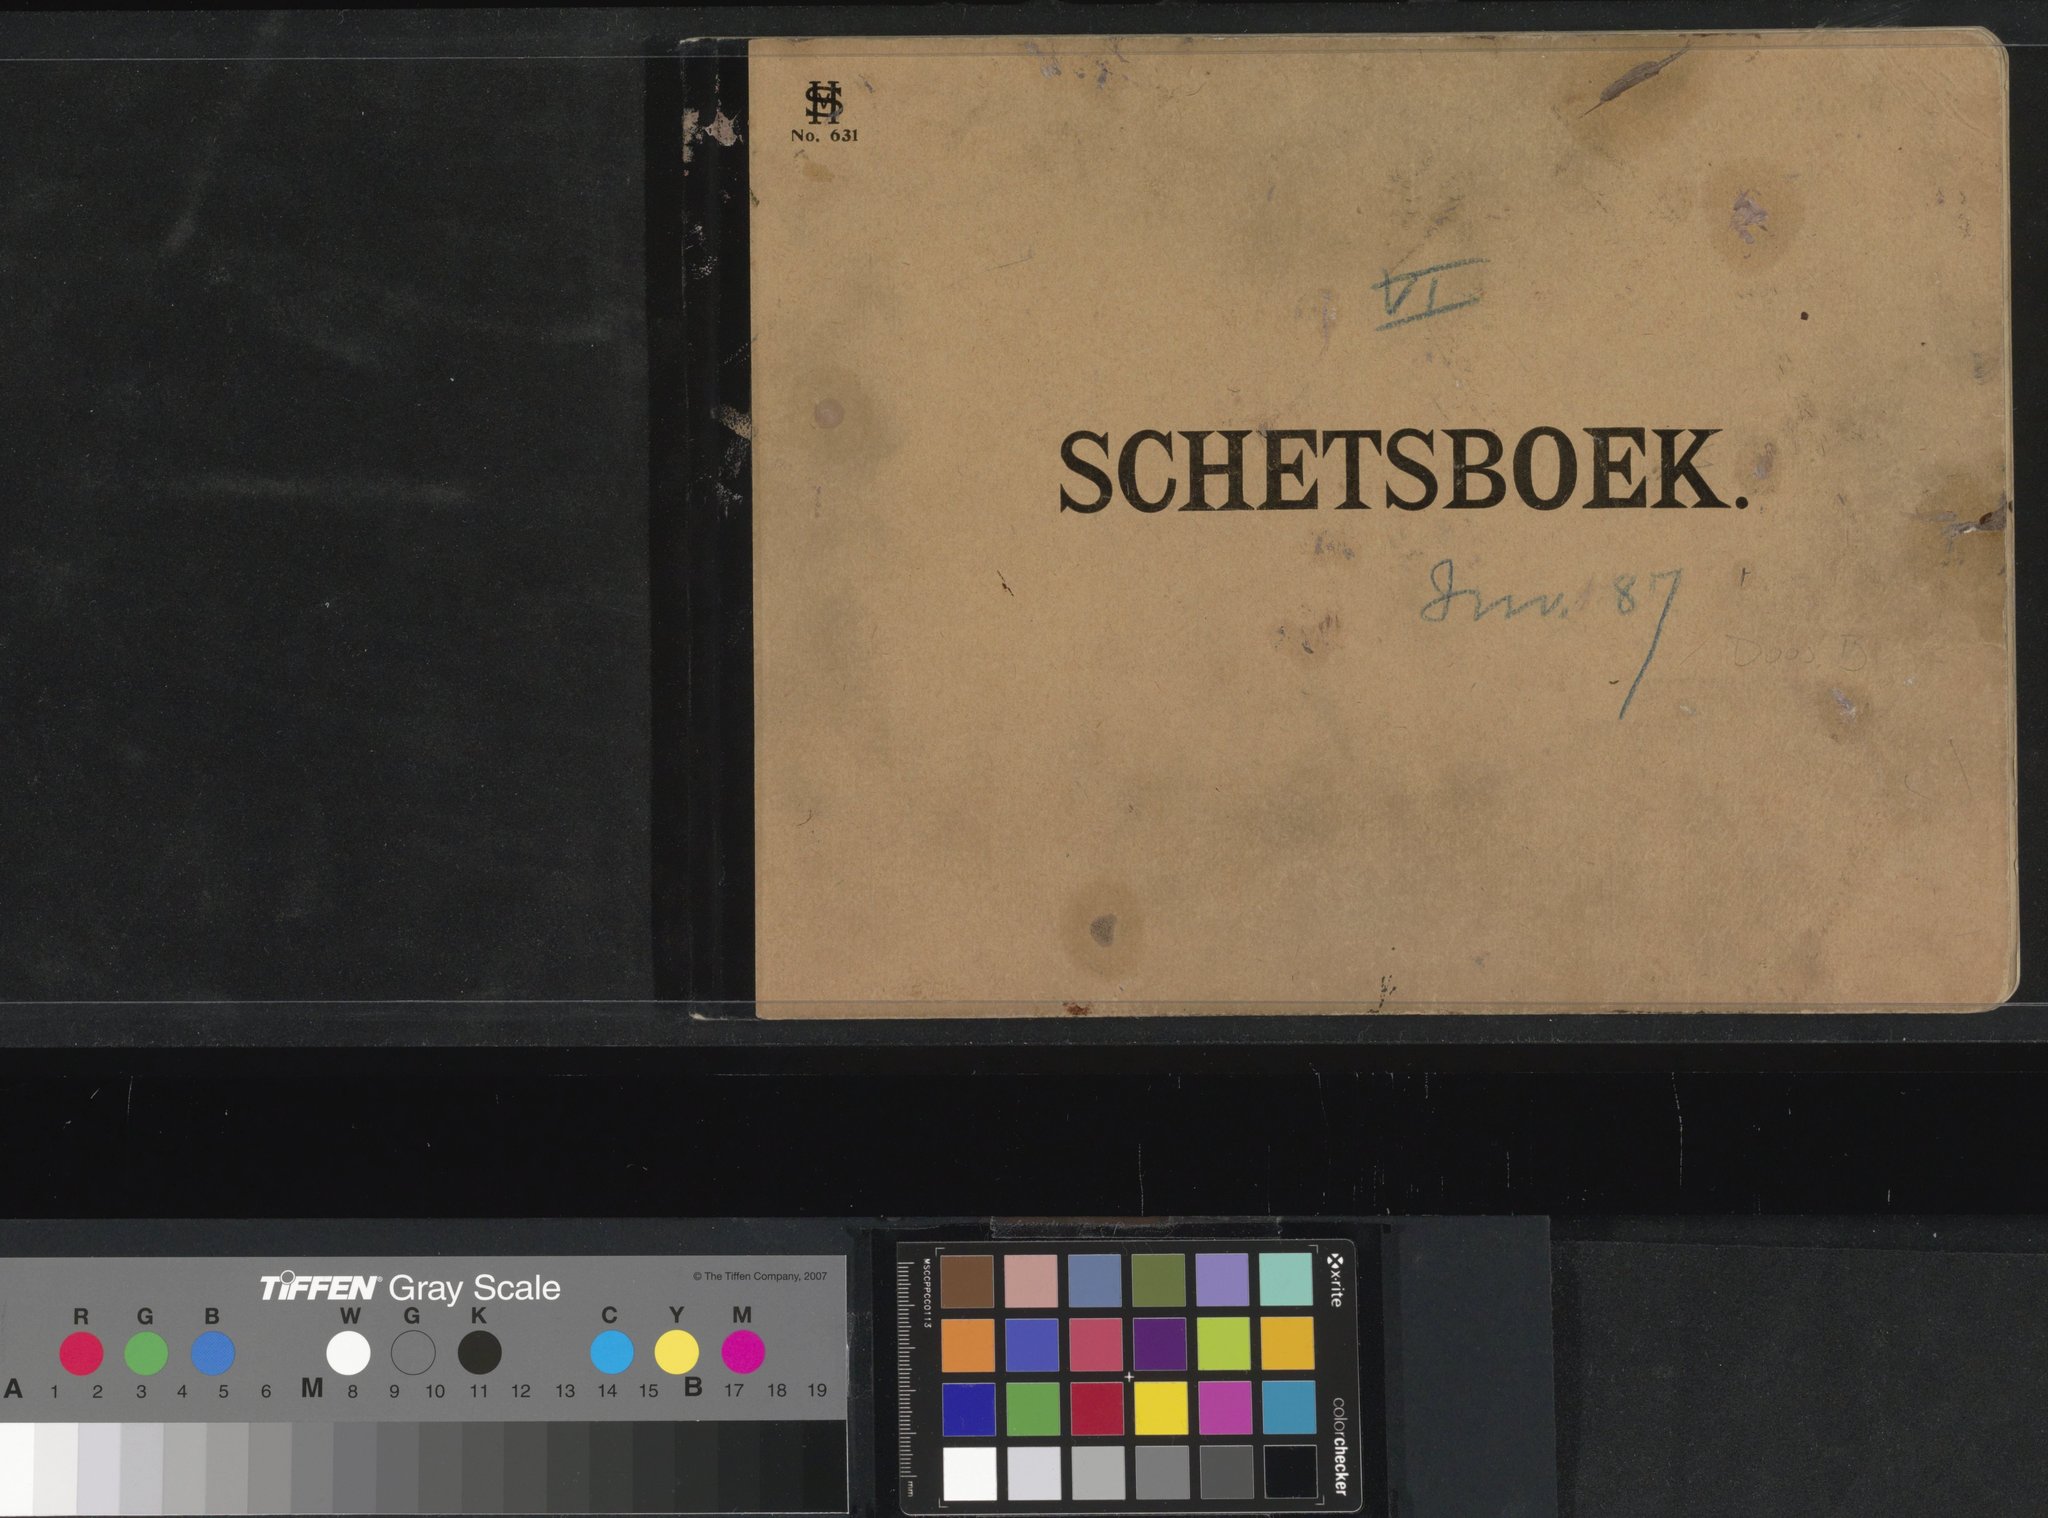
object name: sketchbook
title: Schetsboek VI met 33 bladen met variété en vrouwelijk naakt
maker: isaac israels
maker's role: draughtsman, painter, print maker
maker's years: 1865-1934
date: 1915-1934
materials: cardboard, chalk, ink, linen, paper, pencil, watercolor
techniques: brush, pen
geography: the hague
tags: adult woman, vaudeville, variety-show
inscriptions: collector's mark: Lugt 2228, monogram: ‘HvS / No. 631’, title: ‘Schetsboek’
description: Bladen 5(V), 6(V), 7(V), 19(R), 21(V), 26(V), 28(R), 30(R), 31(V), 32(R) en het voorste schutblad zijn blanco en daarom niet beschreven.